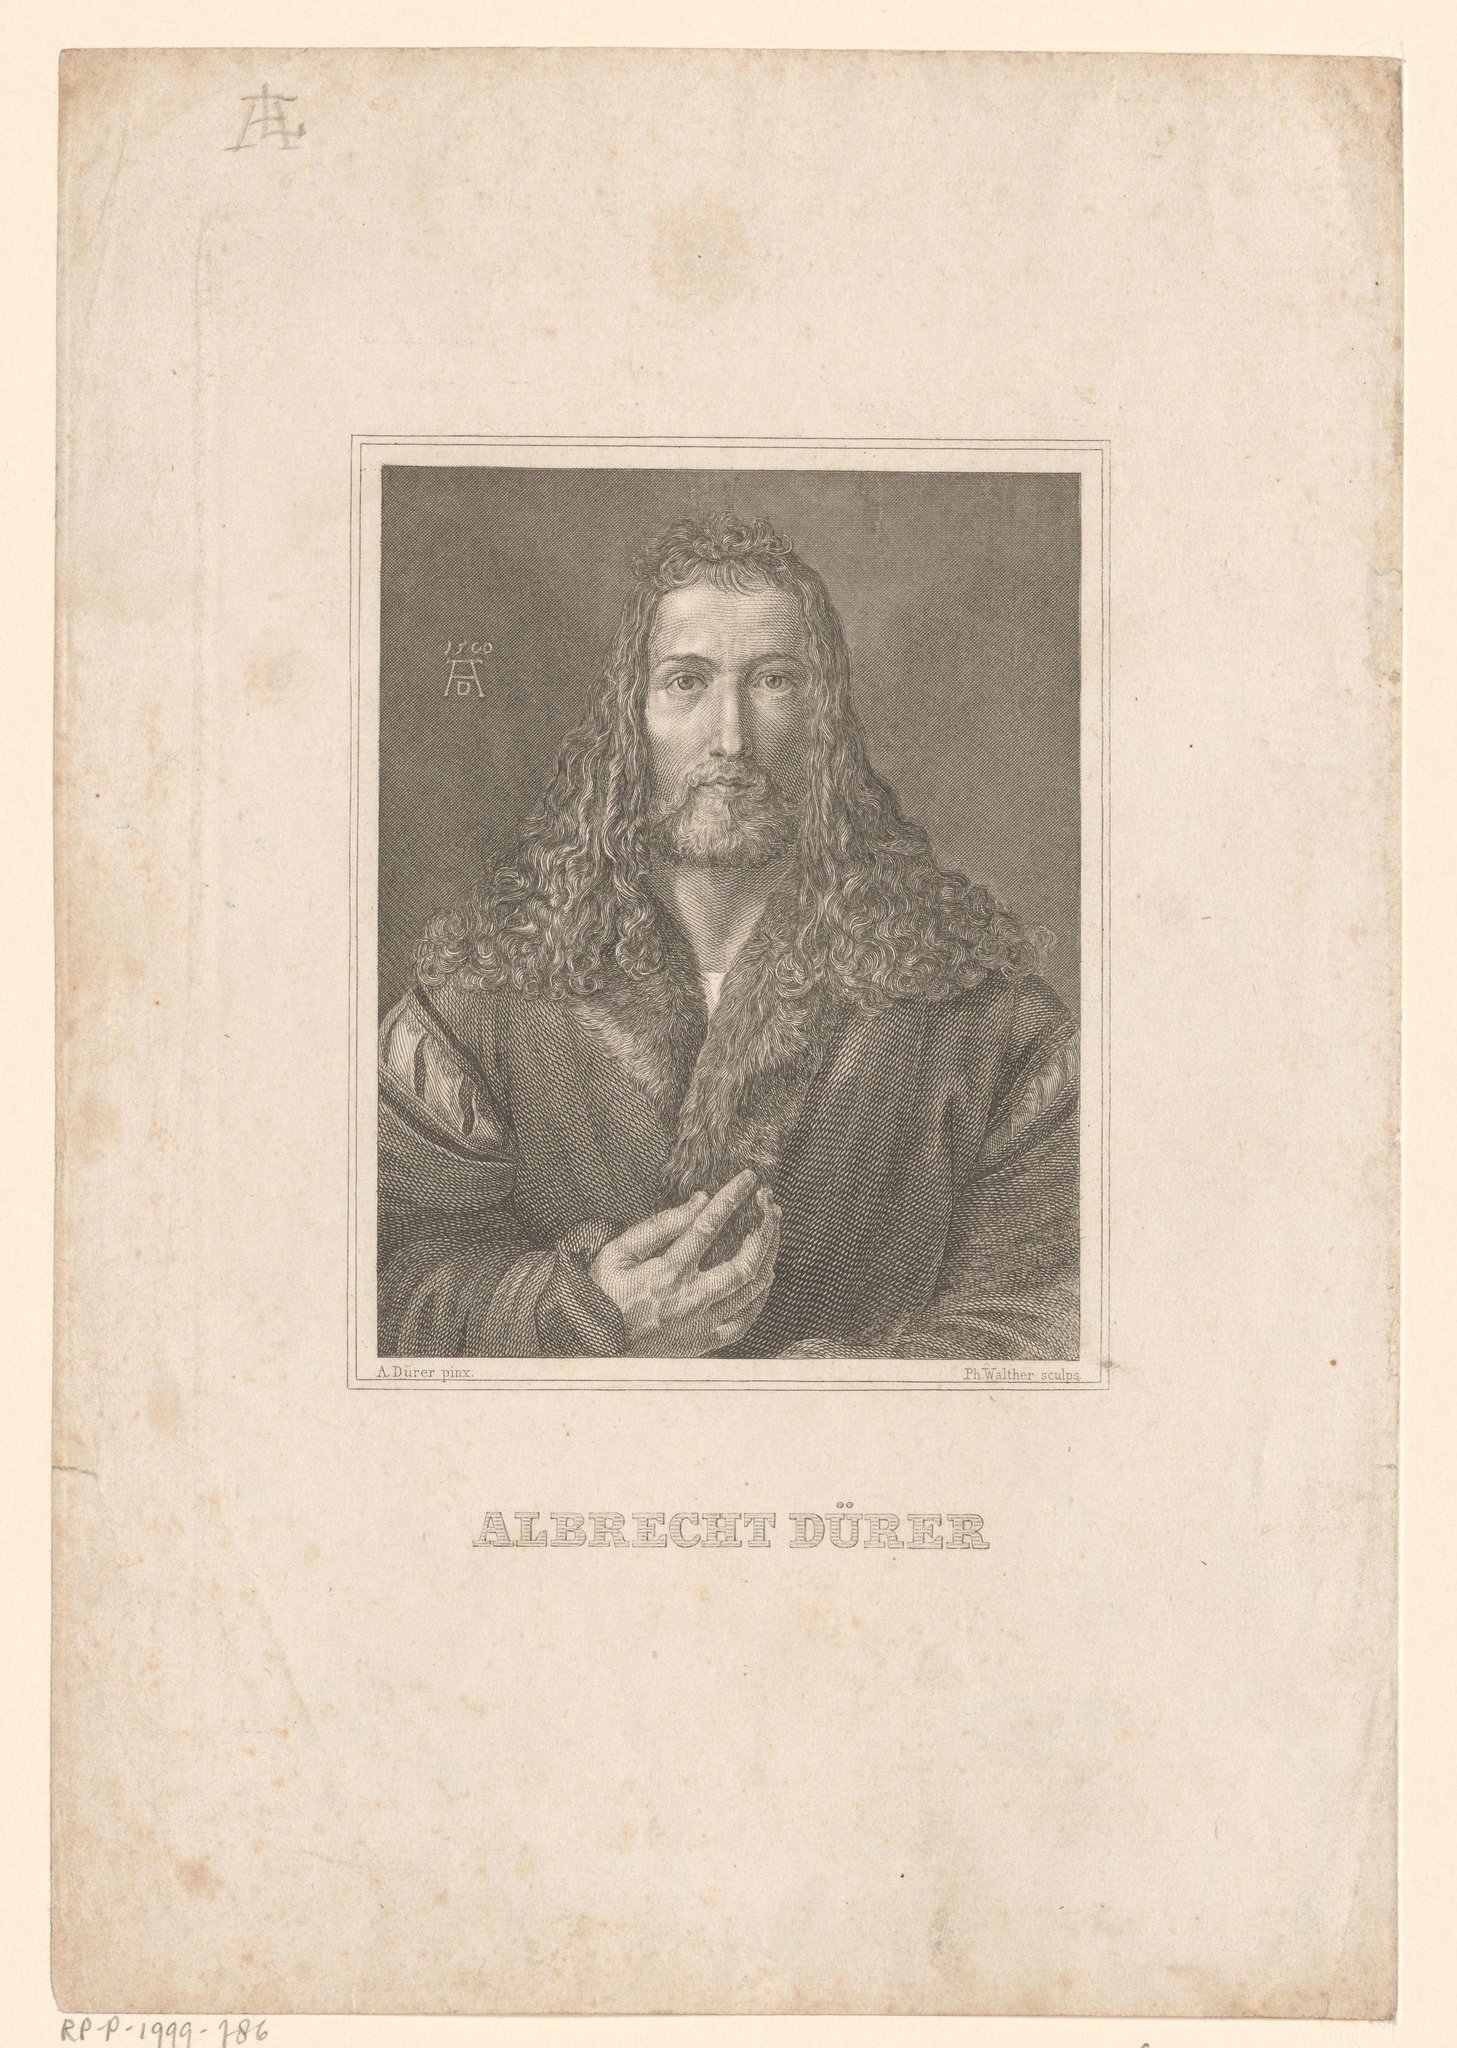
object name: print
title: Portret van Albrecht Dürer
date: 1808-1868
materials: paper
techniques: engraving, etching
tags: painter, print maker, draughtsman, albrecht dürer, historical persons, portrait, self-portrait of painter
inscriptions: collector's mark: Lugt 2228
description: Portret van Albrecht Dürer (1471-1528), naar zijn zelfportret uit 1500. Buste, van voren gezien, met lange haren, de rechterhand voor de borst. Links het monogram AD.